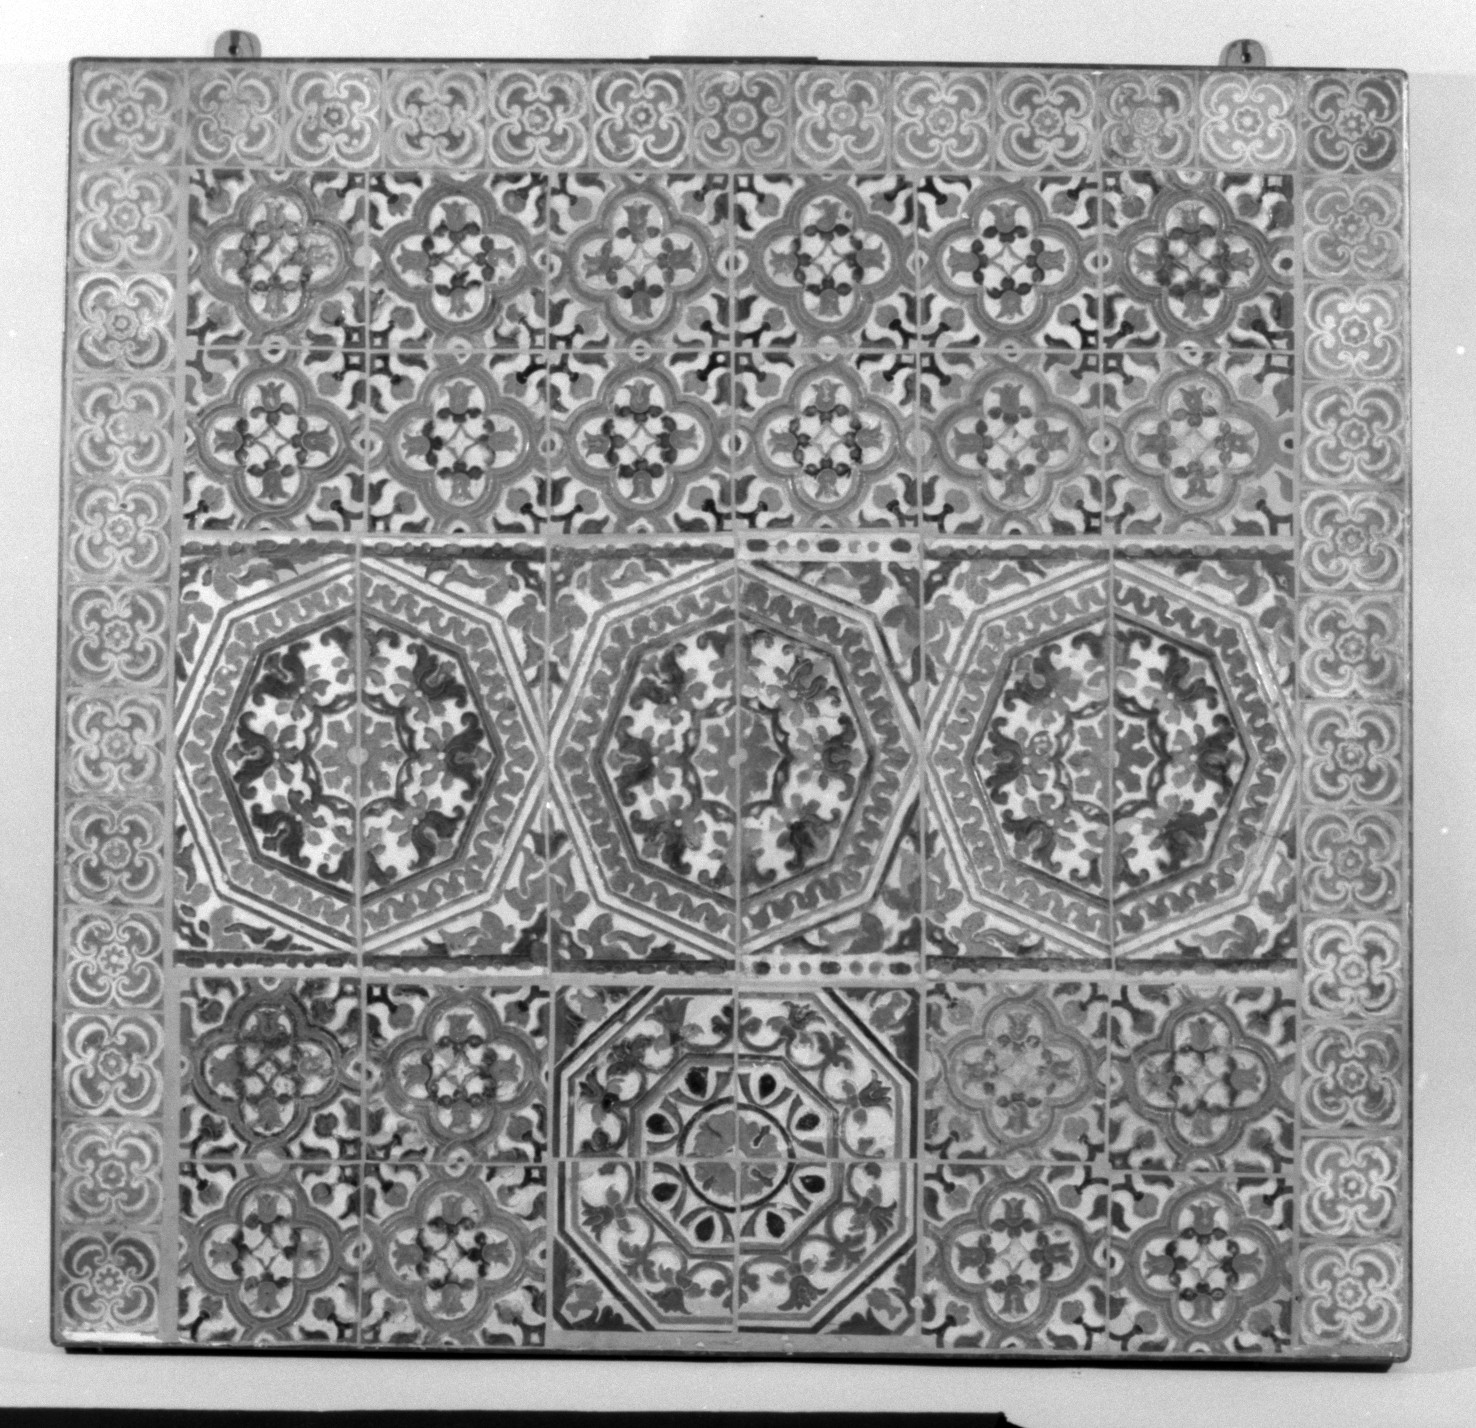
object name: tile panel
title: Panel of tiles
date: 1501-1600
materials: earthenware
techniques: glazing